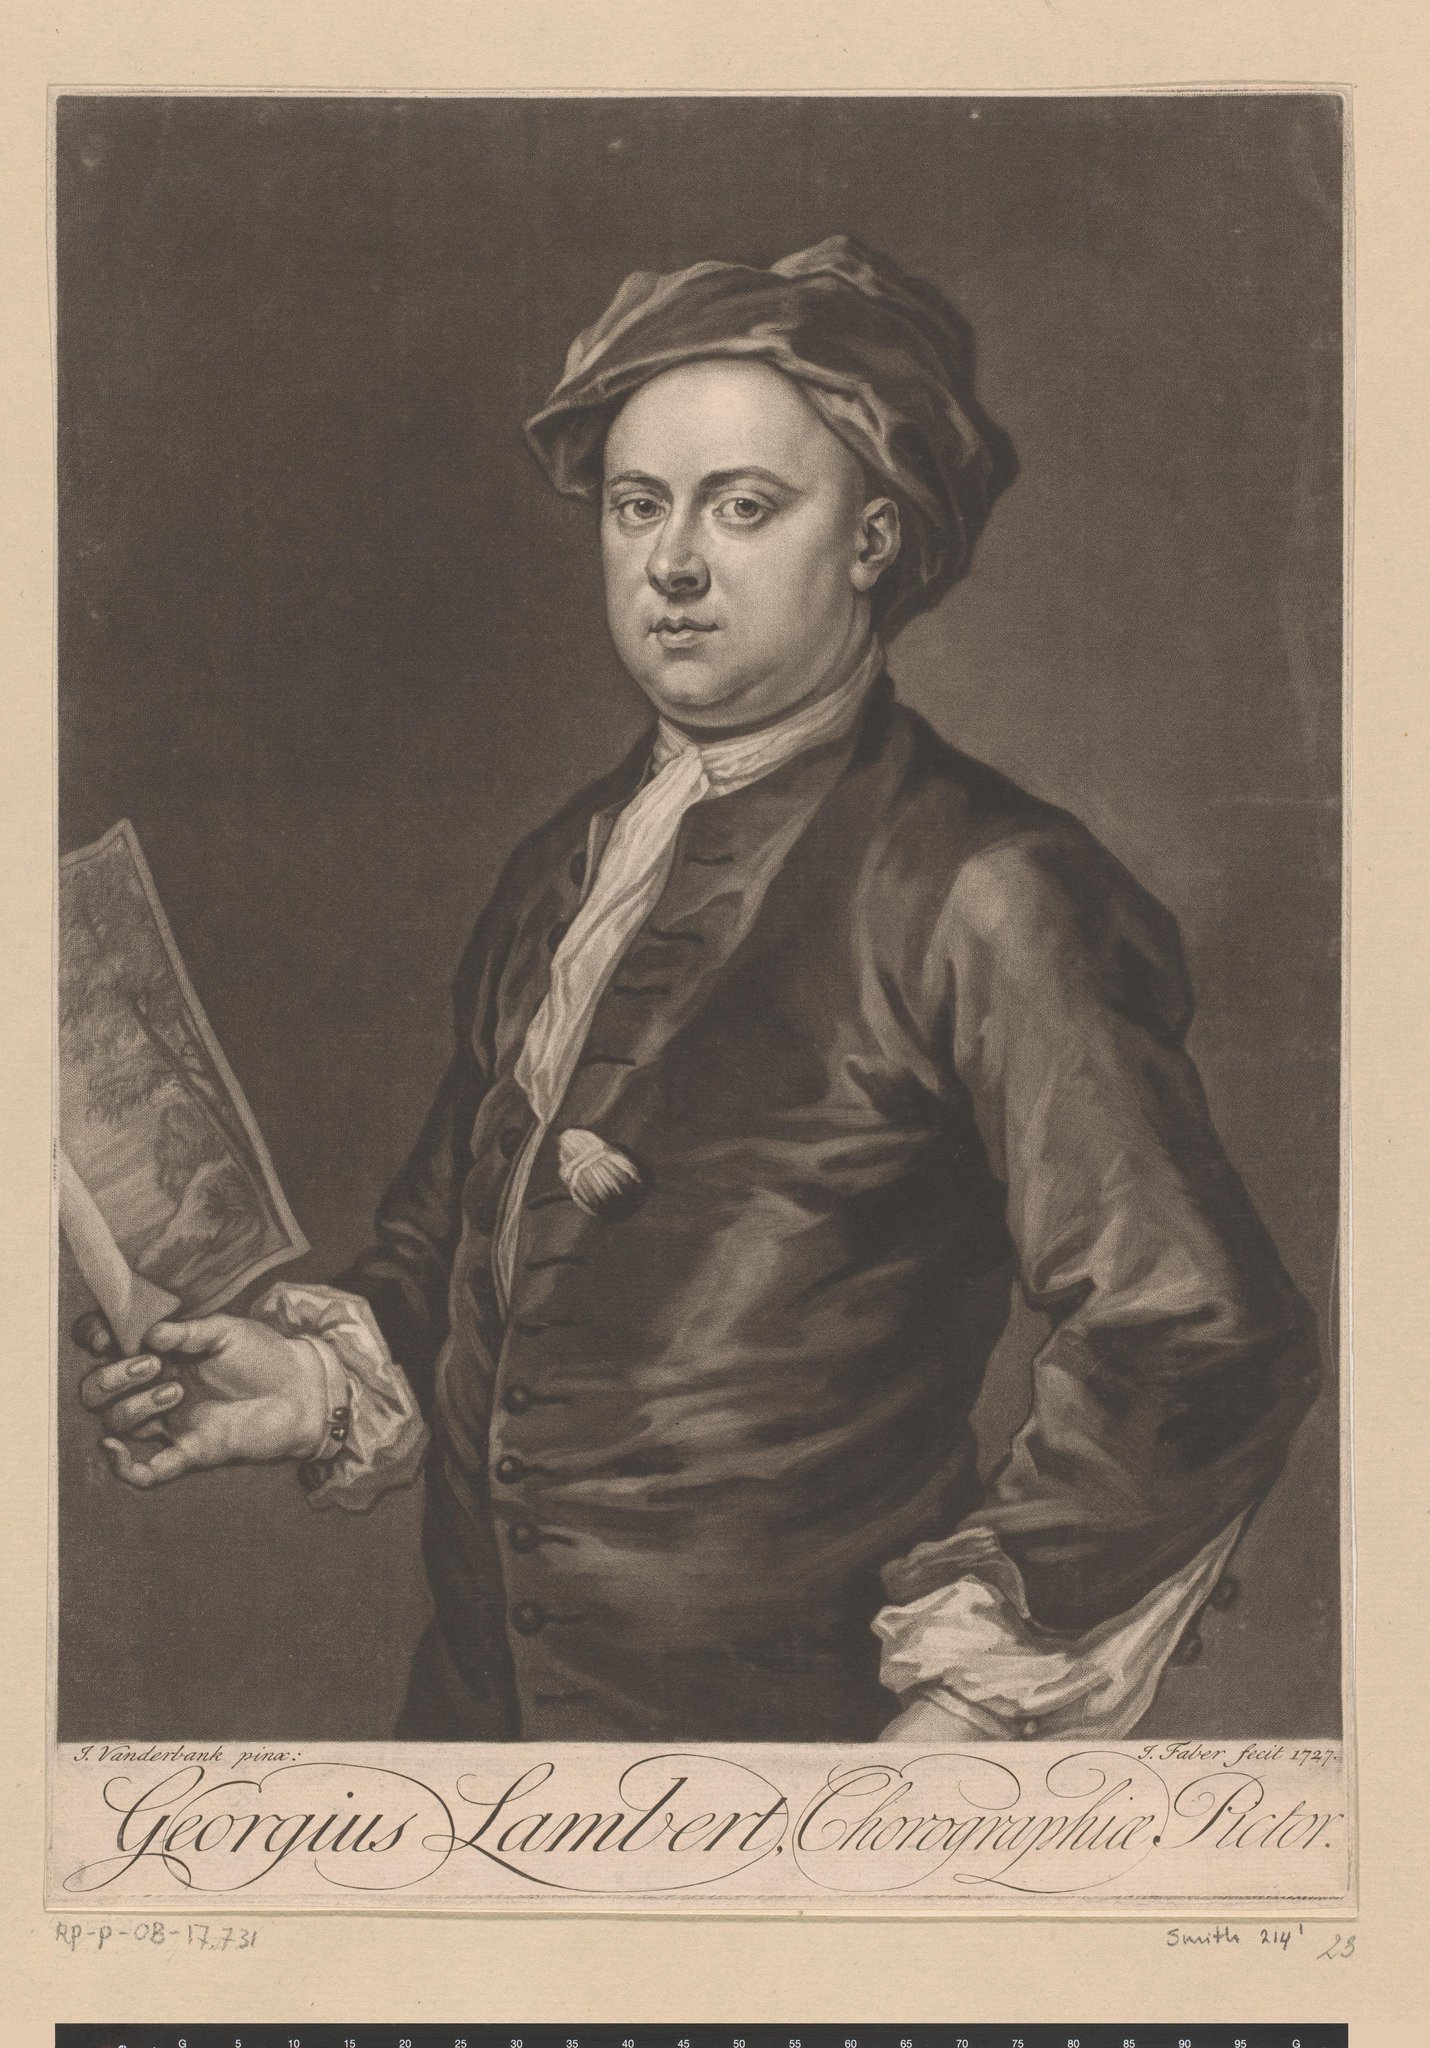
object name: print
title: Portret van George Lambert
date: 1727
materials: paper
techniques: mezzotint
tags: london, print maker, george lambert, historical persons, portrait, self-portrait of painter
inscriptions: collector's mark: Lugt 240